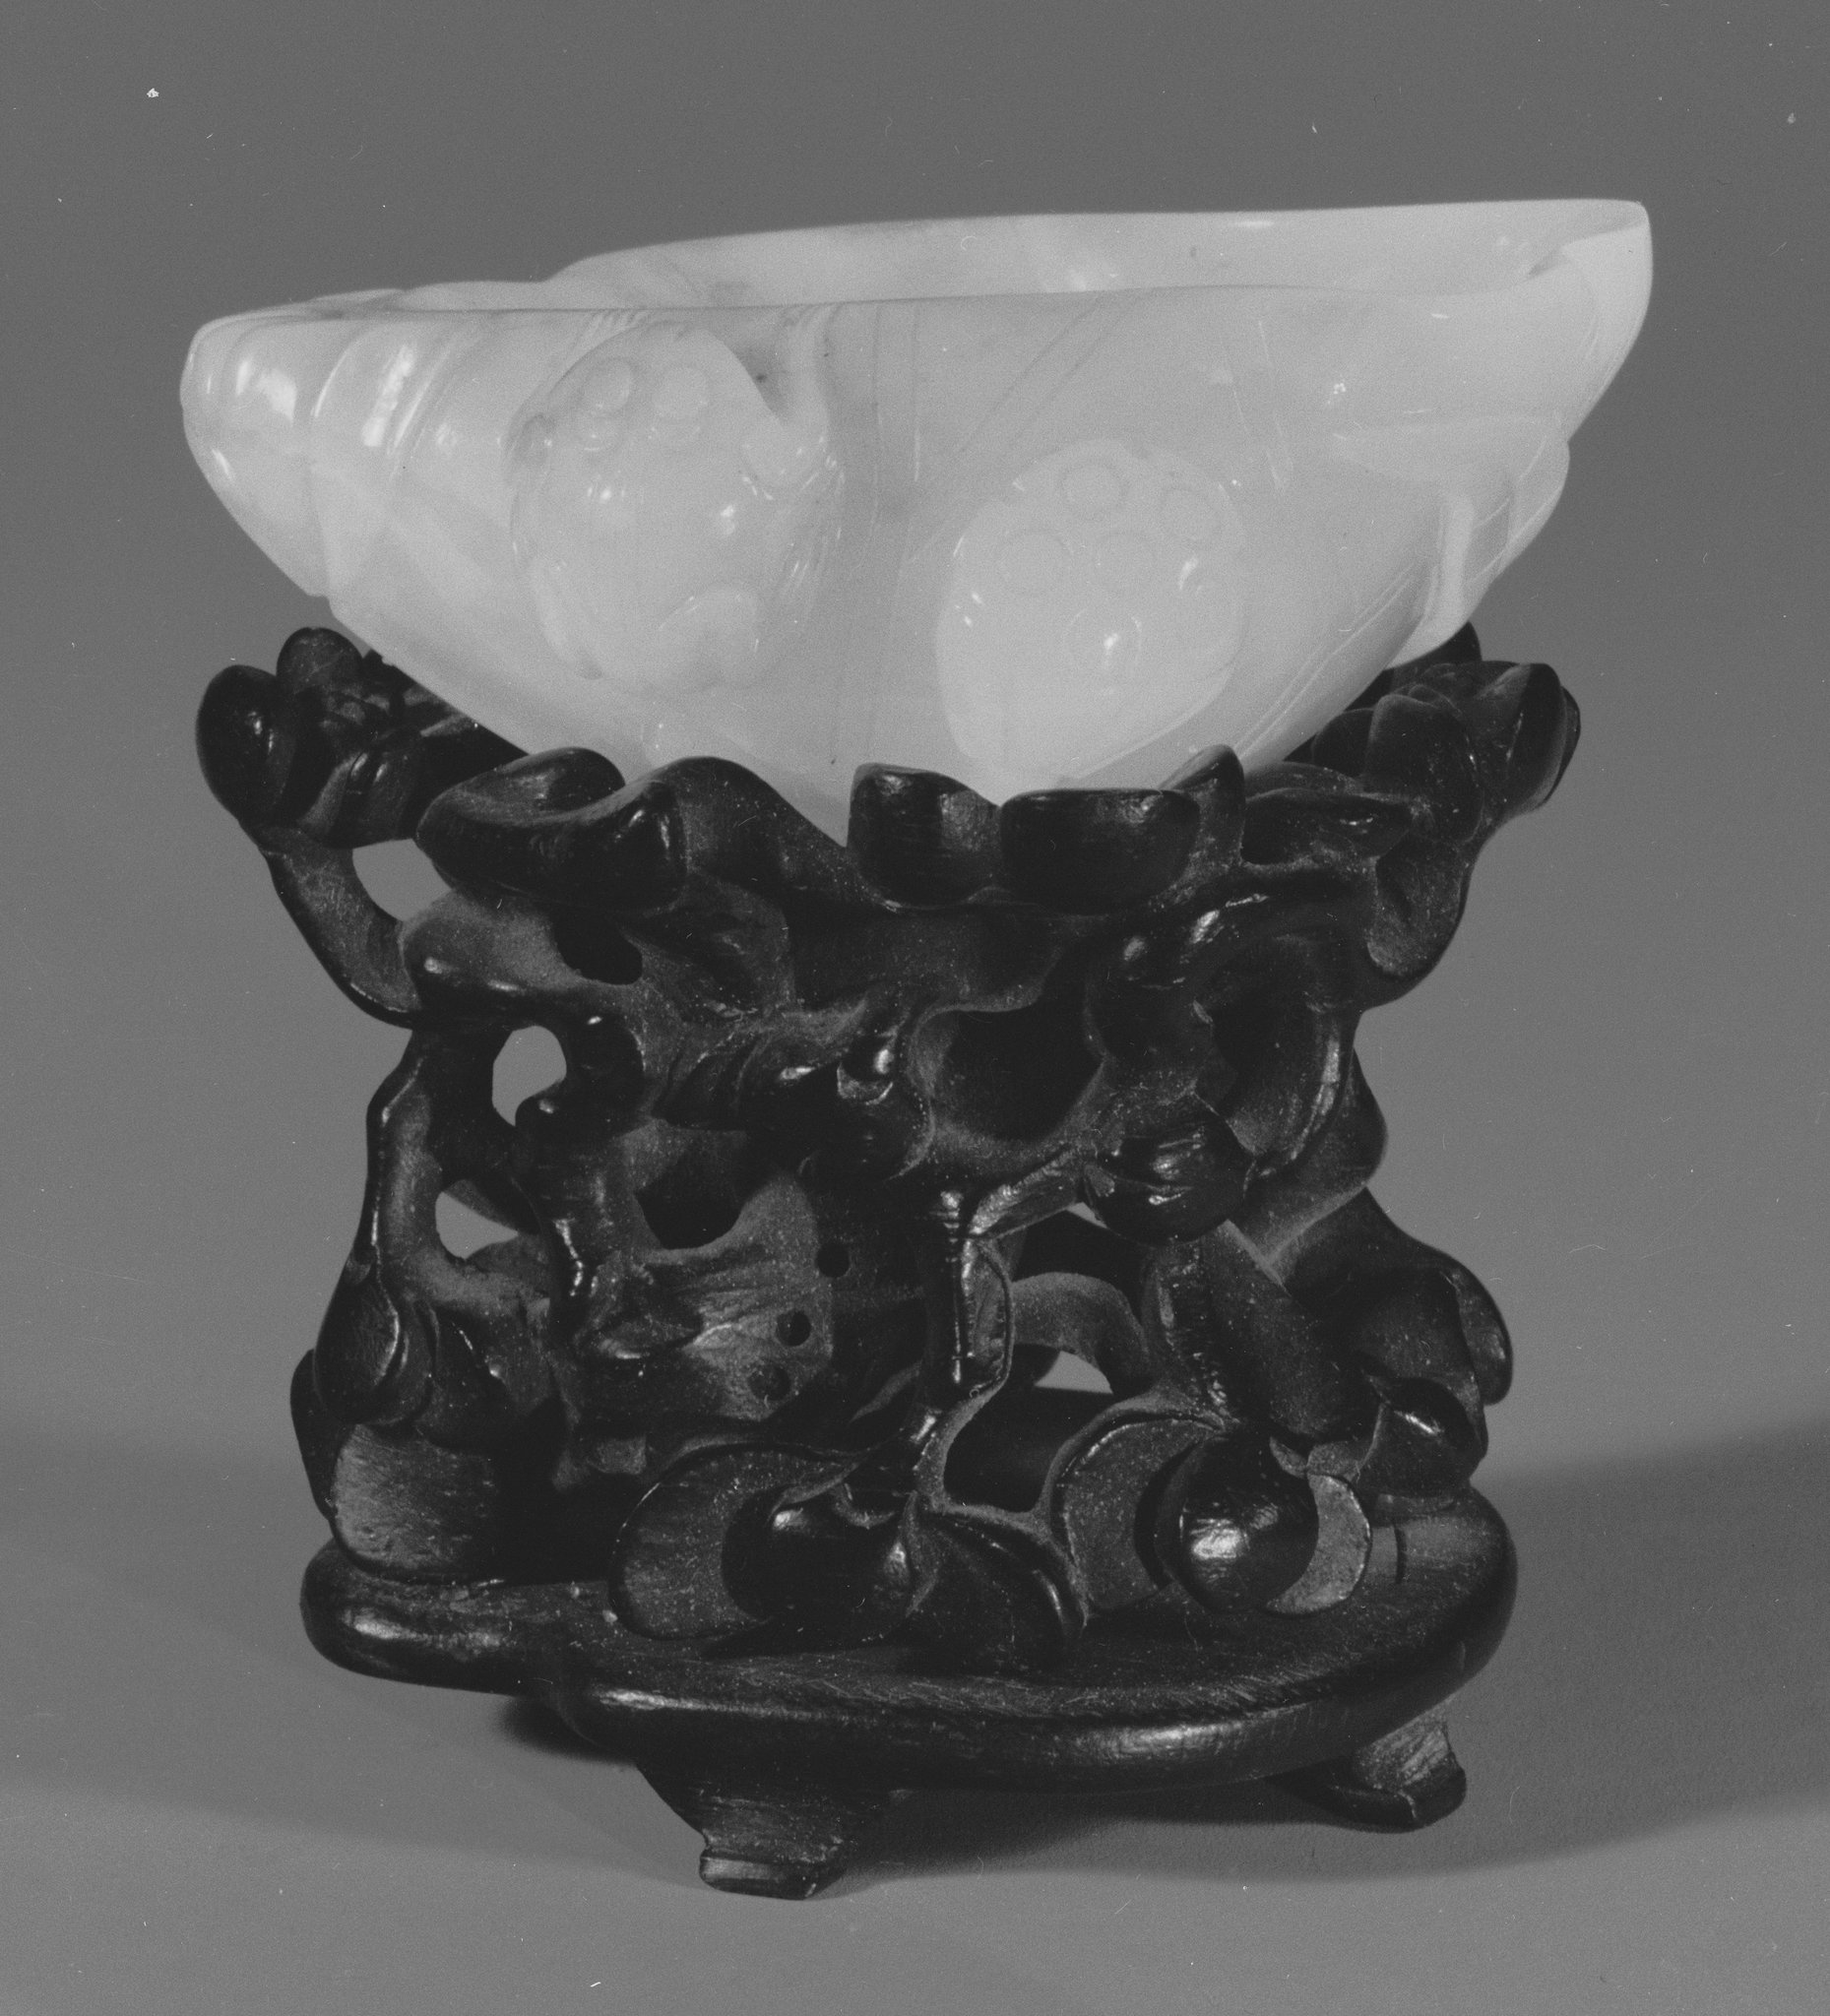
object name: water jar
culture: chinese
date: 1867-1900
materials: jade